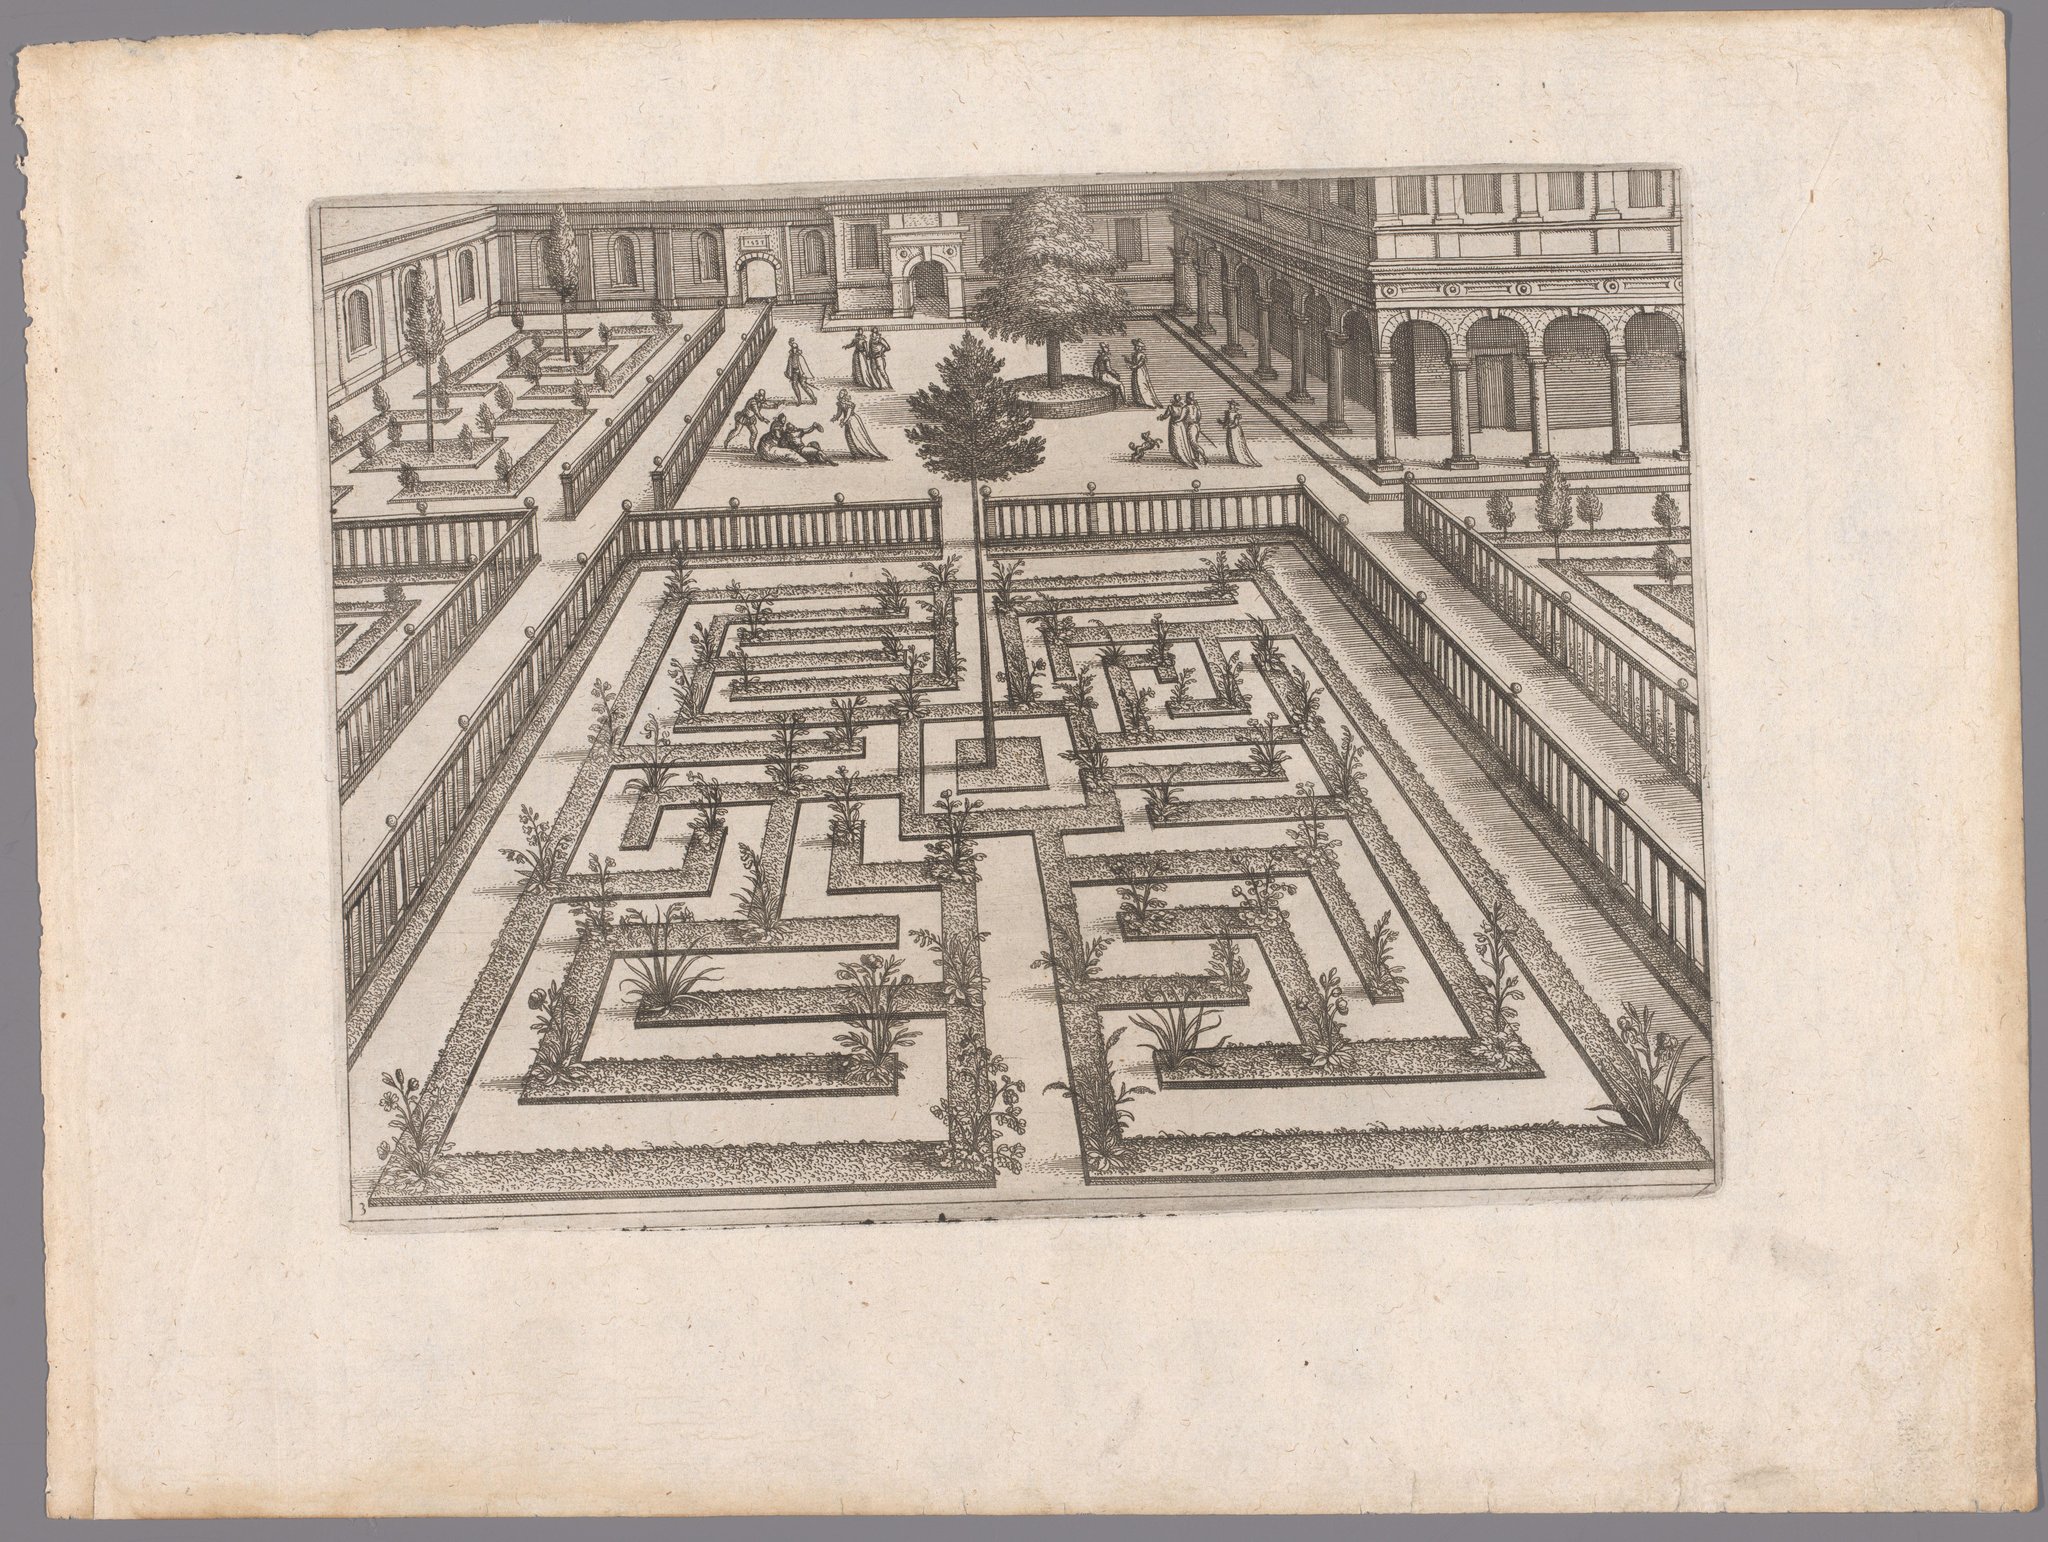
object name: print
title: Tuinen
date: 1587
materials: paper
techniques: etching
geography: antwerp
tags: garden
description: Deel van een ontmanteld album waarvan RP-P-2013-1-54-1 t/m -37, RP-P-2013-1-55-1 en -2 en RP-P-2013-1-63 en 65 t/m 67 ook deel waren.